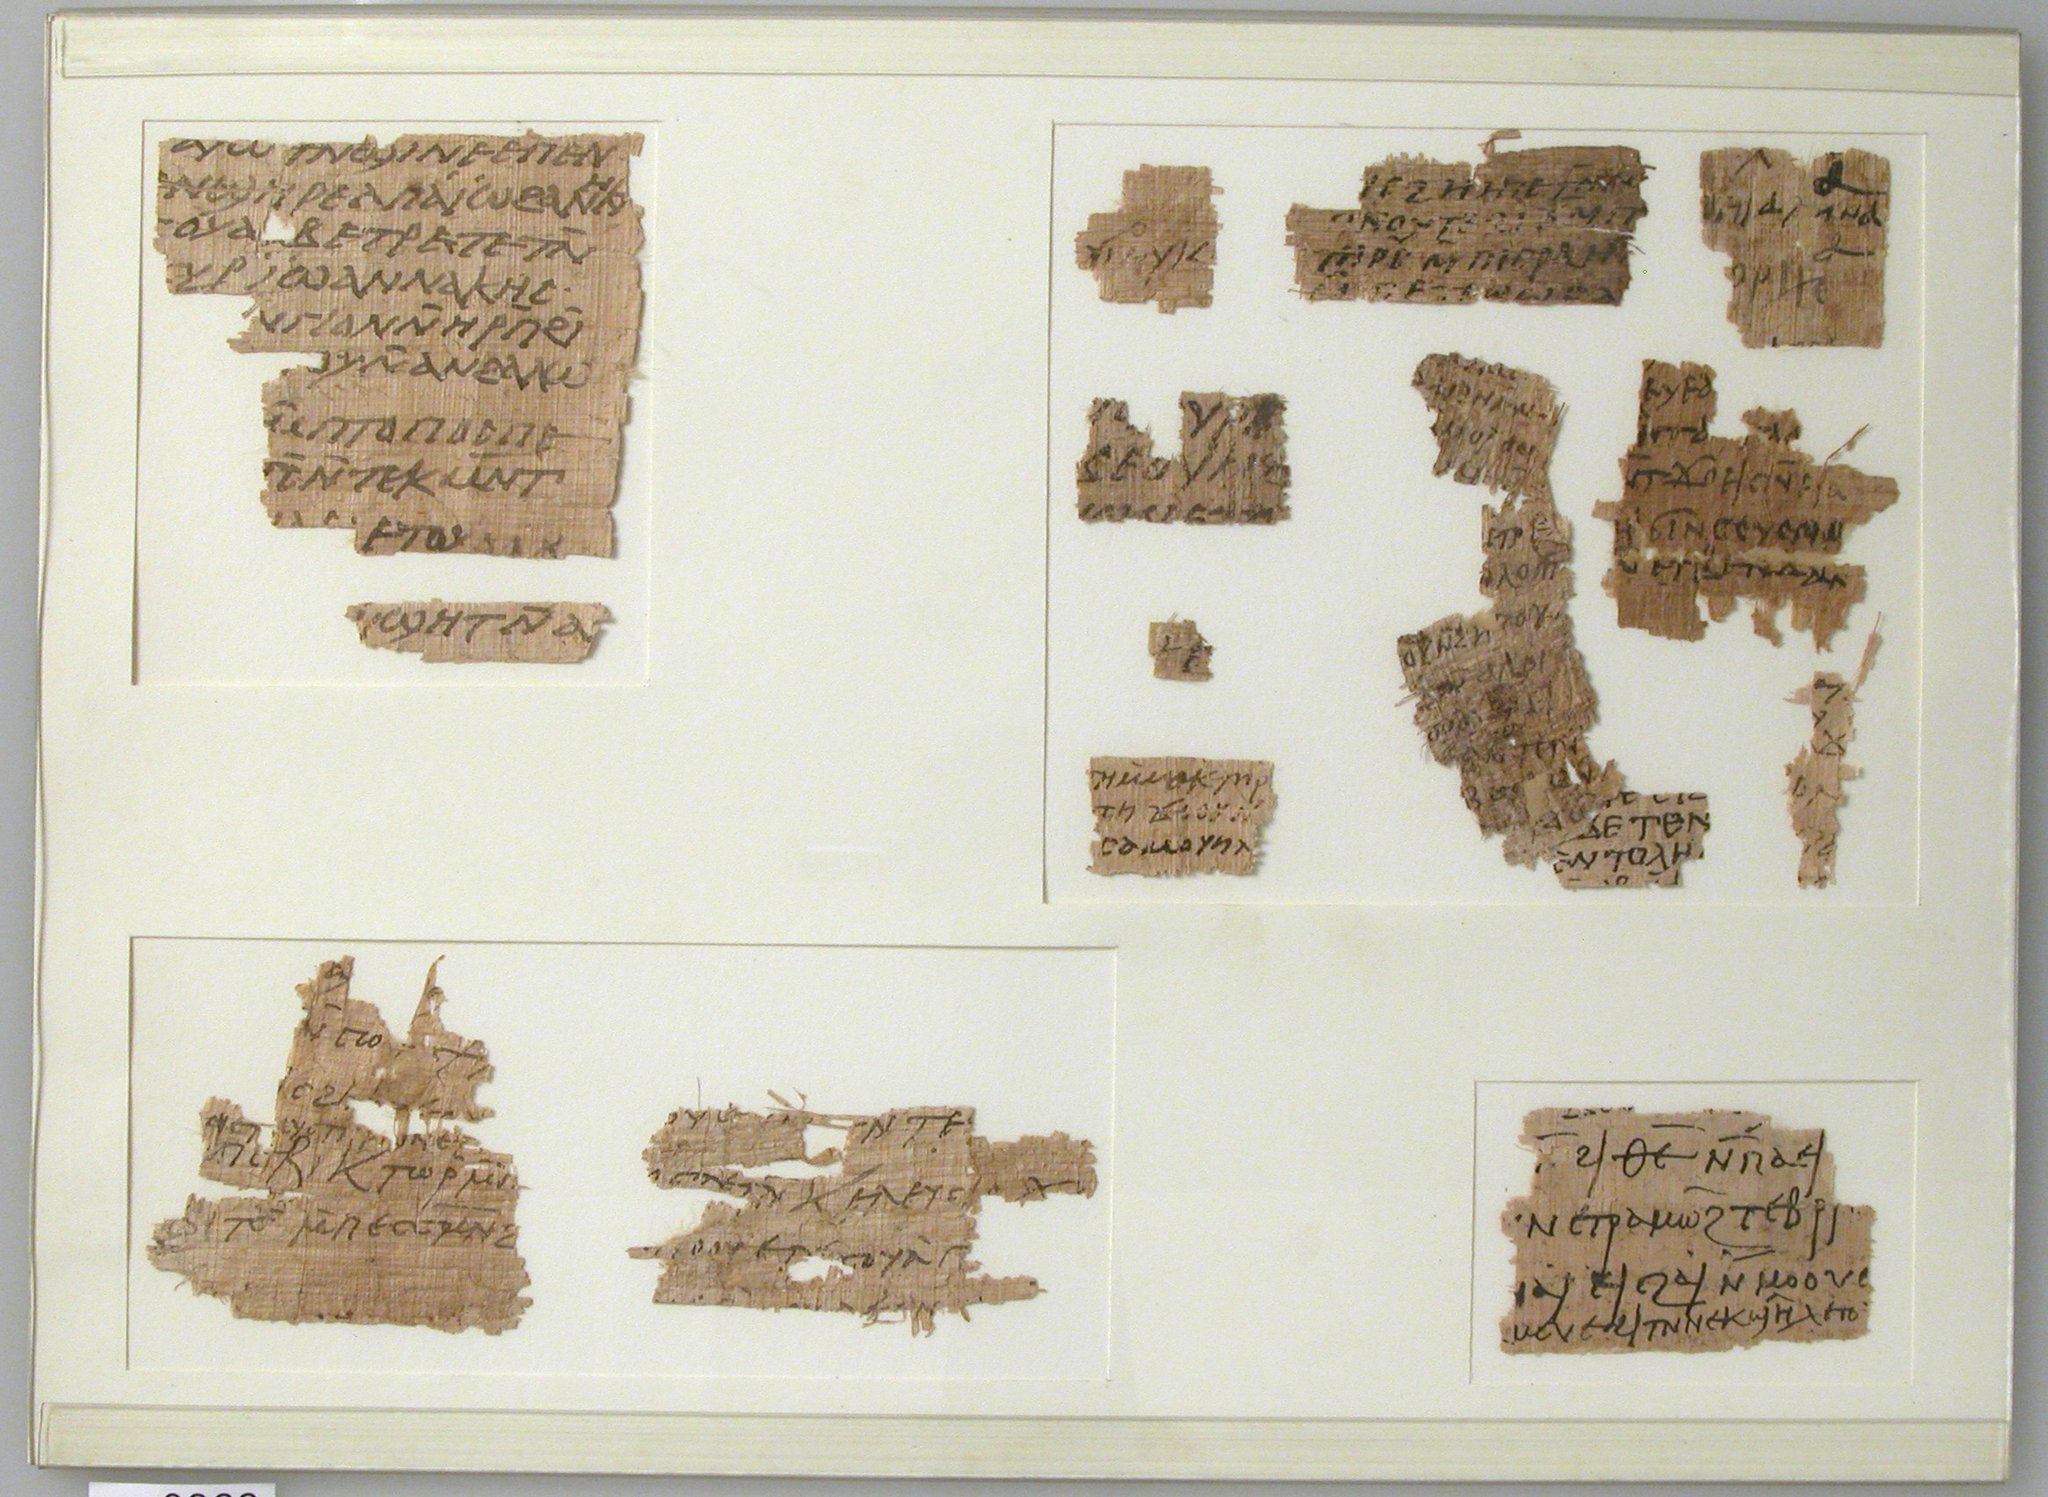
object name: fragment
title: Papyri Fragments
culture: coptic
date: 601-700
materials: ink, papyrus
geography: egypt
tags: documents